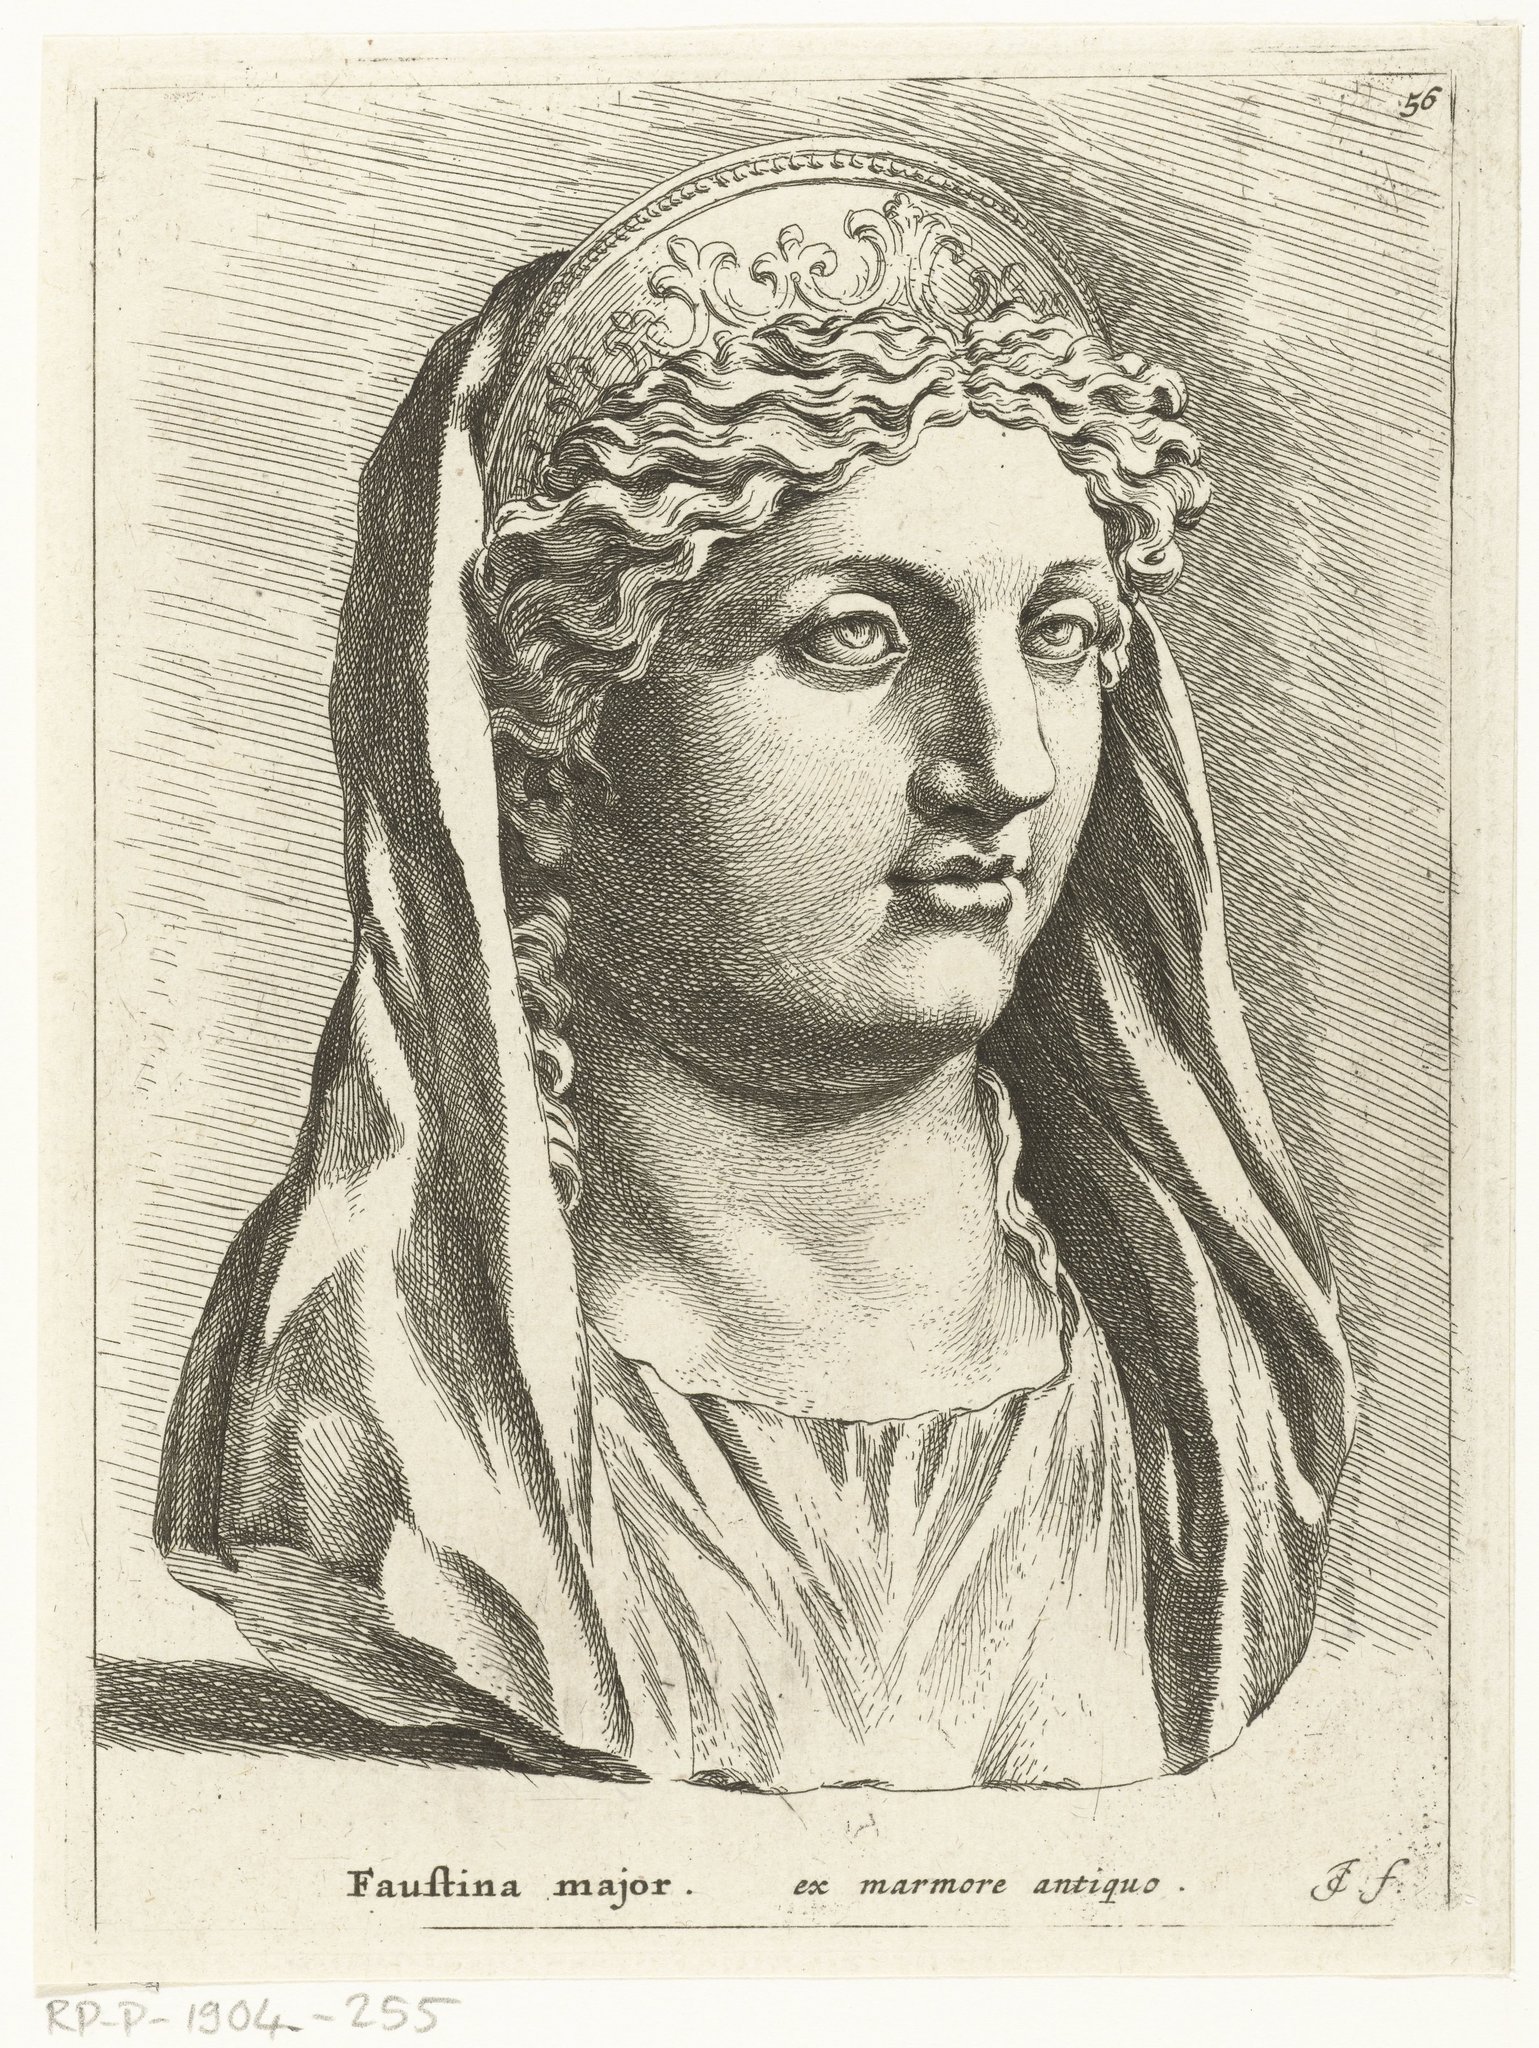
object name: print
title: Paradigmata graphices variorum artificum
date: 1666-1671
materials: paper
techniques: etching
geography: northern netherlands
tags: queen, empress, etc. (wife of a ruler), historical persons (portraits and scenes from the life) (+ three-quarter view portrait)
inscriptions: collector's mark: Lugt 2228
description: Antieke buste van een vrouw met een diadeem in haar haar en een doek op haar hoofd. Na onderzoek is gebleken dat het niet gaat om de keizerin Faustina.